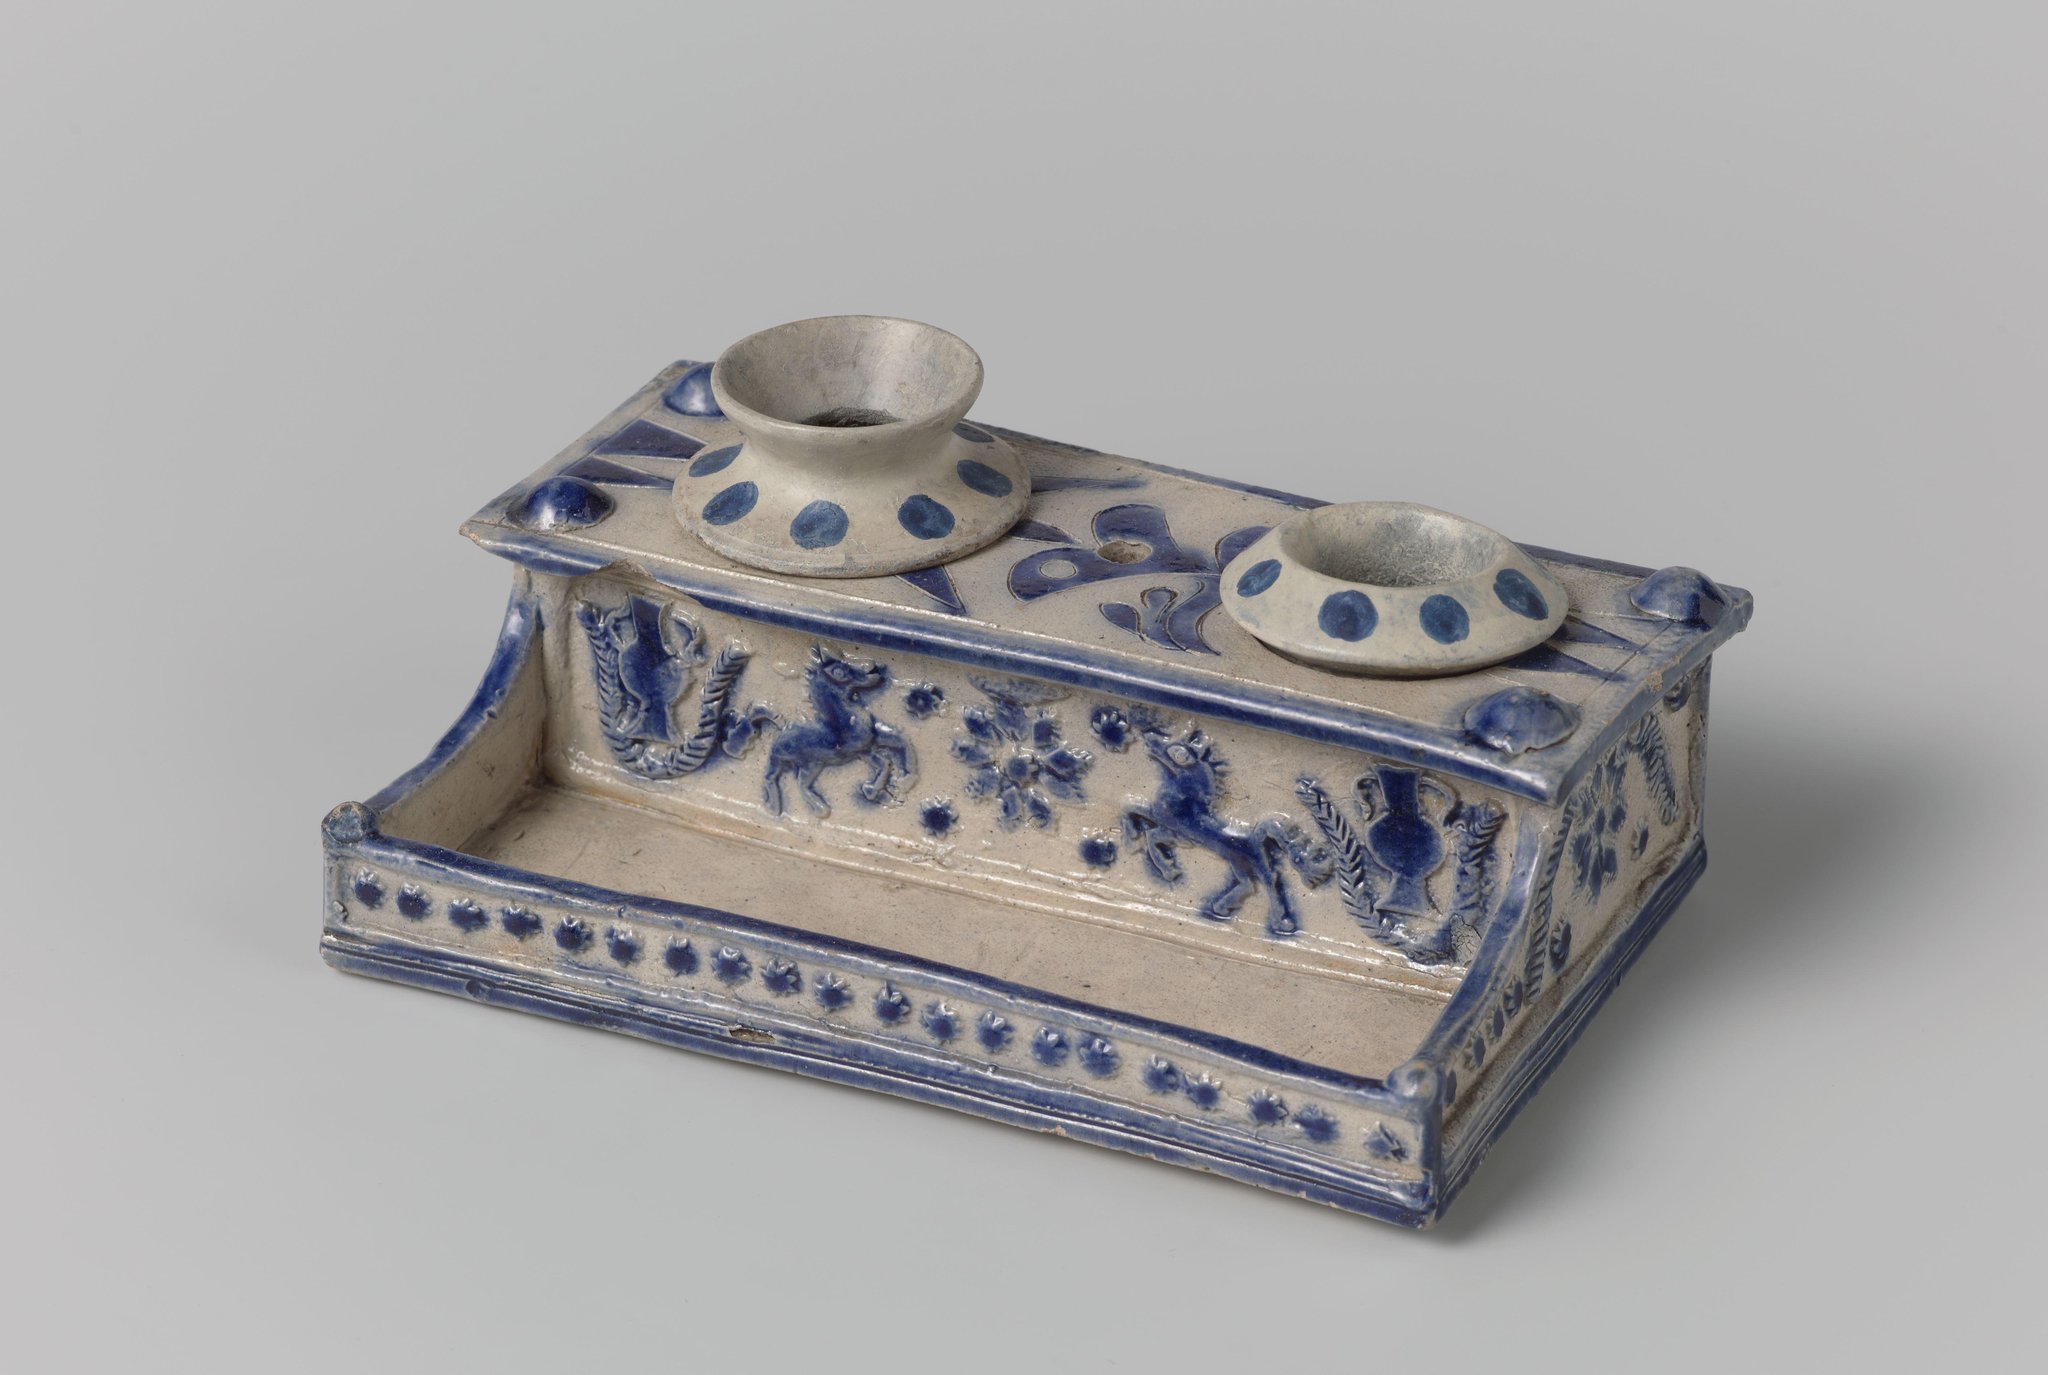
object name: inkstand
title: Sand shaker with blue dots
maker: Anonymous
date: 1750-1799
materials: glaze, paint, stoneware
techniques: firing, forming, turning, vitrification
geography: westerwald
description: Zandstrooier van steengoed met een cilindervormig lichaam en uitstekende rand om in de houder te hangen. Beschilderd met blauwe stippen. Westerwald.